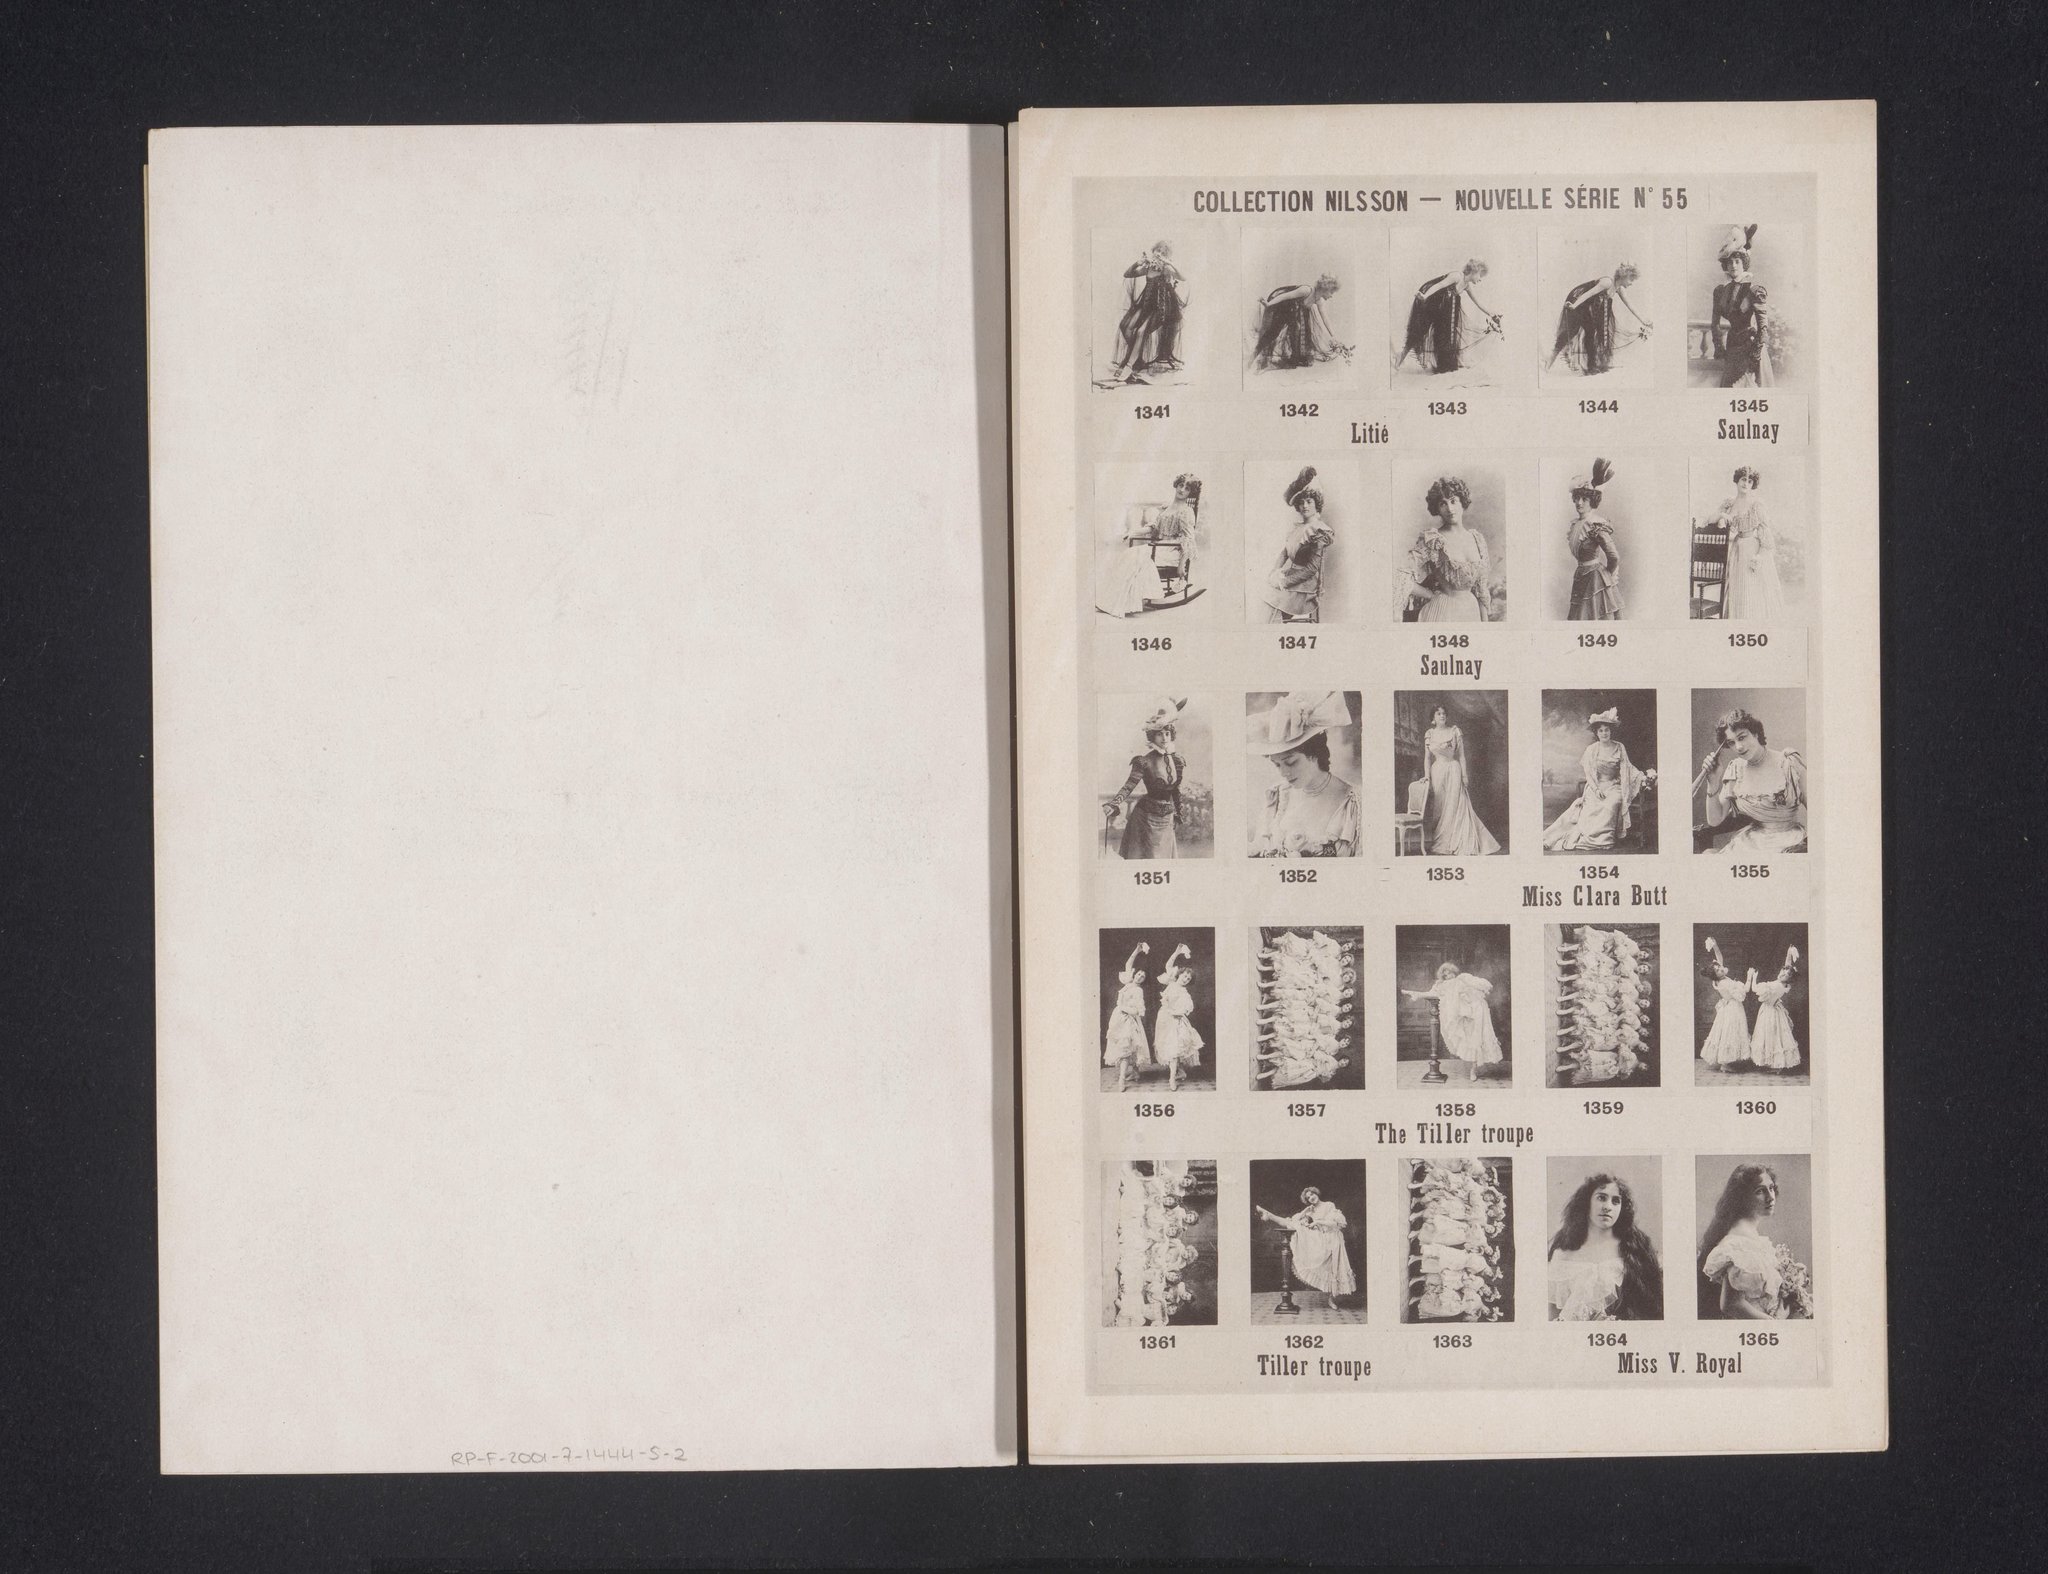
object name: page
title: 25 portretten van Litié, Saulnay, zangeres Clara Butt, The Tiller Troupe en Miss V. Royal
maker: Anonymous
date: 1892-1897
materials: paper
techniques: photograph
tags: portrait of artiste (dancer, actor, etc.), historical persons - bb - woman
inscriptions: number: ‘No 55’